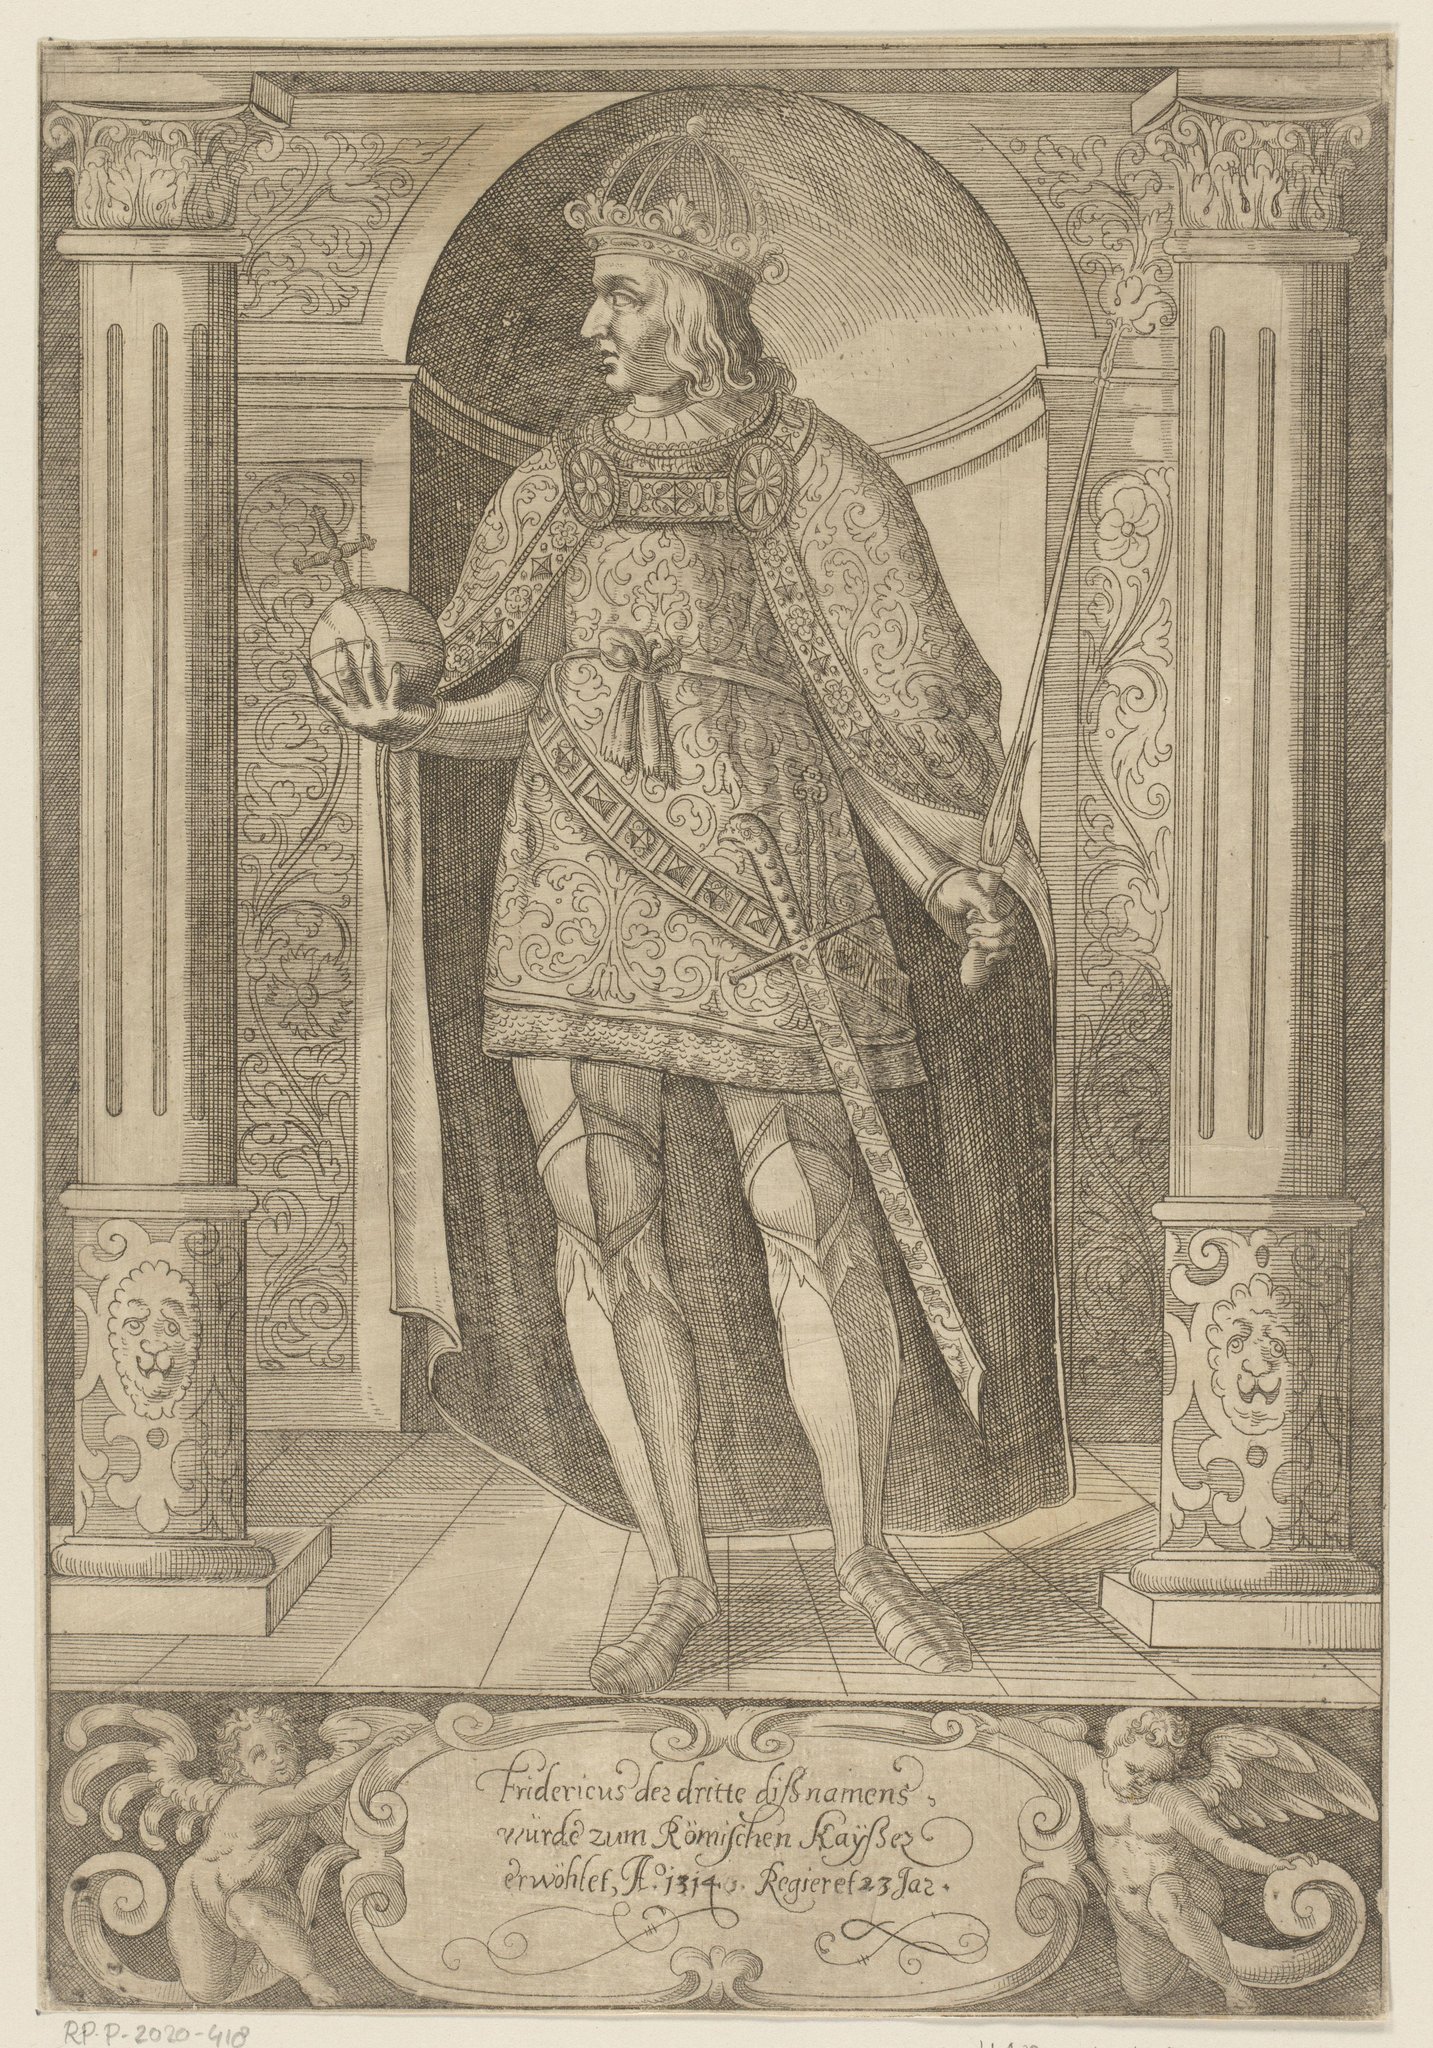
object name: print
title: Portret van Frederik de Schone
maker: lukas schnitzer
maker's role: draughtsman, painter, print maker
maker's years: 1600-1674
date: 1610-1674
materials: paper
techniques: etching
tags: column, pillar ~ architecture, historical persons